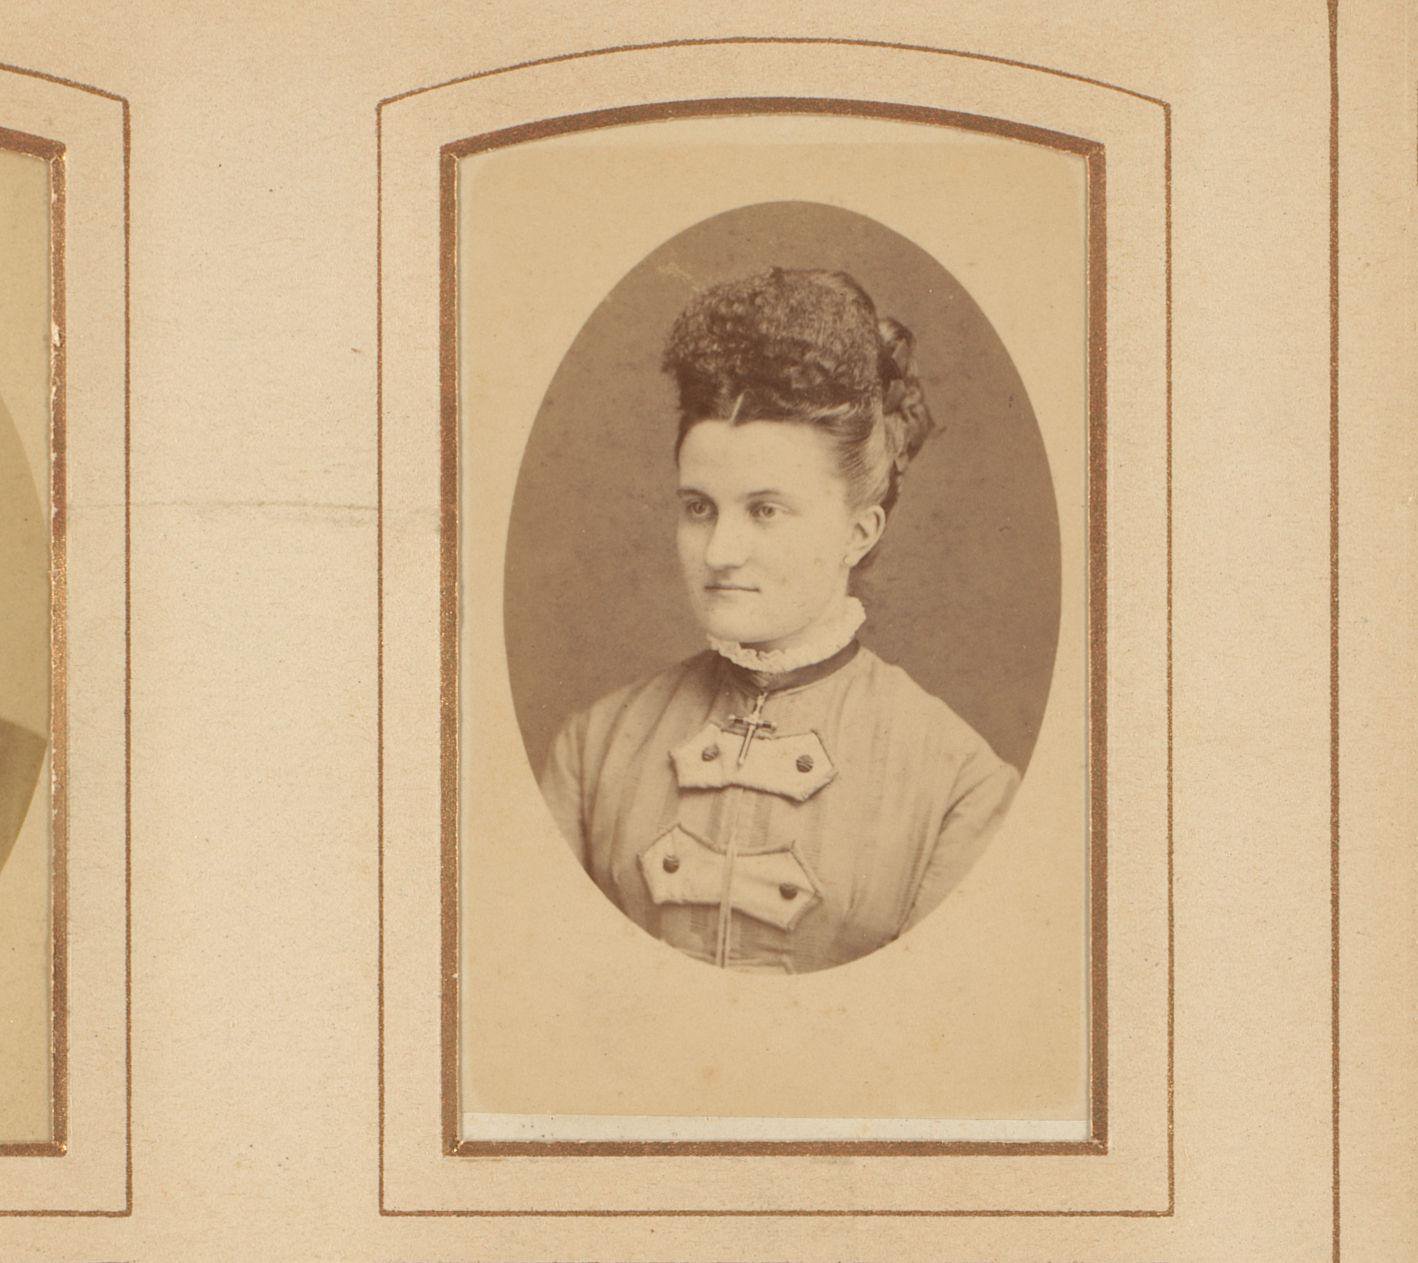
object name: photograph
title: Portret van een vrouw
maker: Anonymous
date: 1870-1900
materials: cardboard, photographic support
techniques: albumen print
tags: historical persons - bb - woman